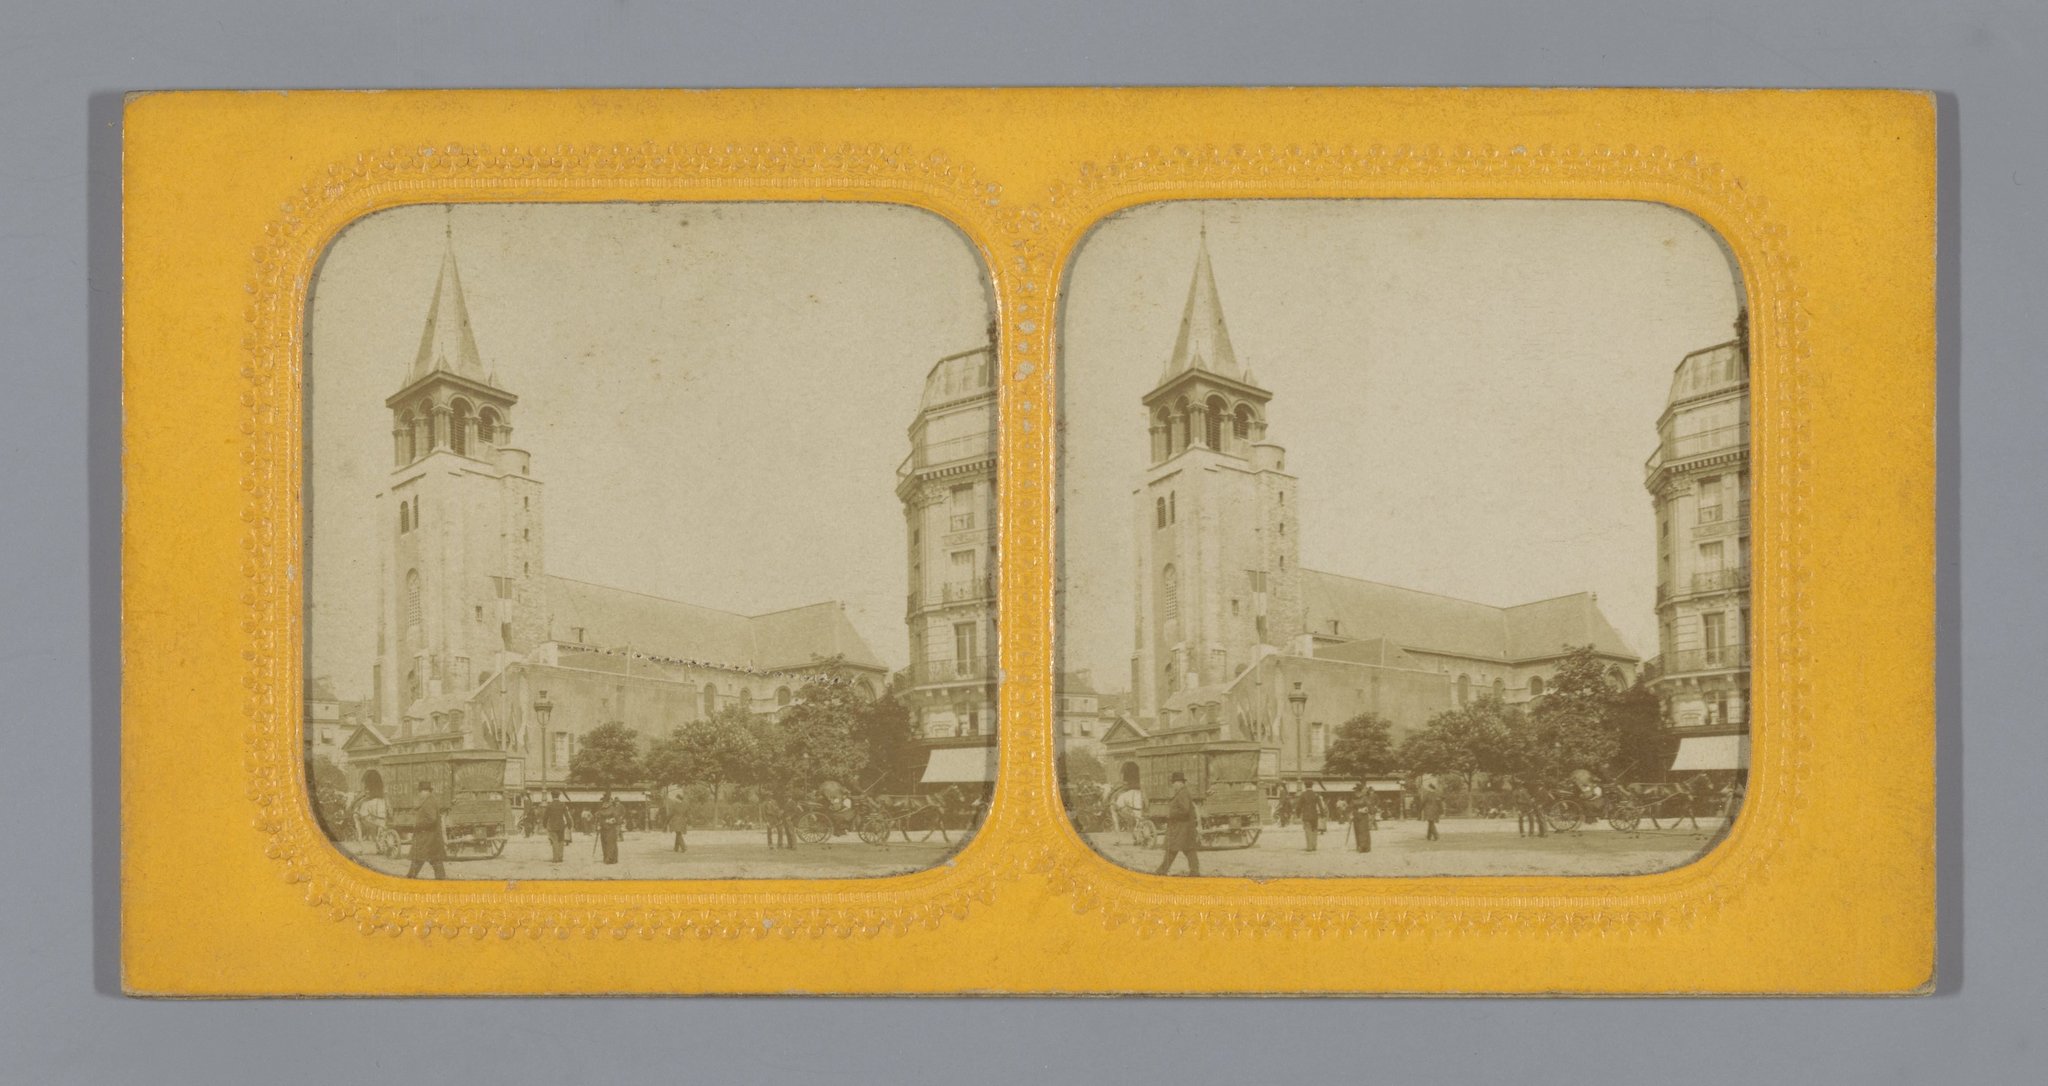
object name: tissue stereograph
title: Exterieur van de Sint-Germanus-van-de-Weidenkerk in Parijs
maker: Anonymous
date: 1855-1875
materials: cardboard, paper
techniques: albumen print, hand coloring, perforating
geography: paris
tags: church (exterior)